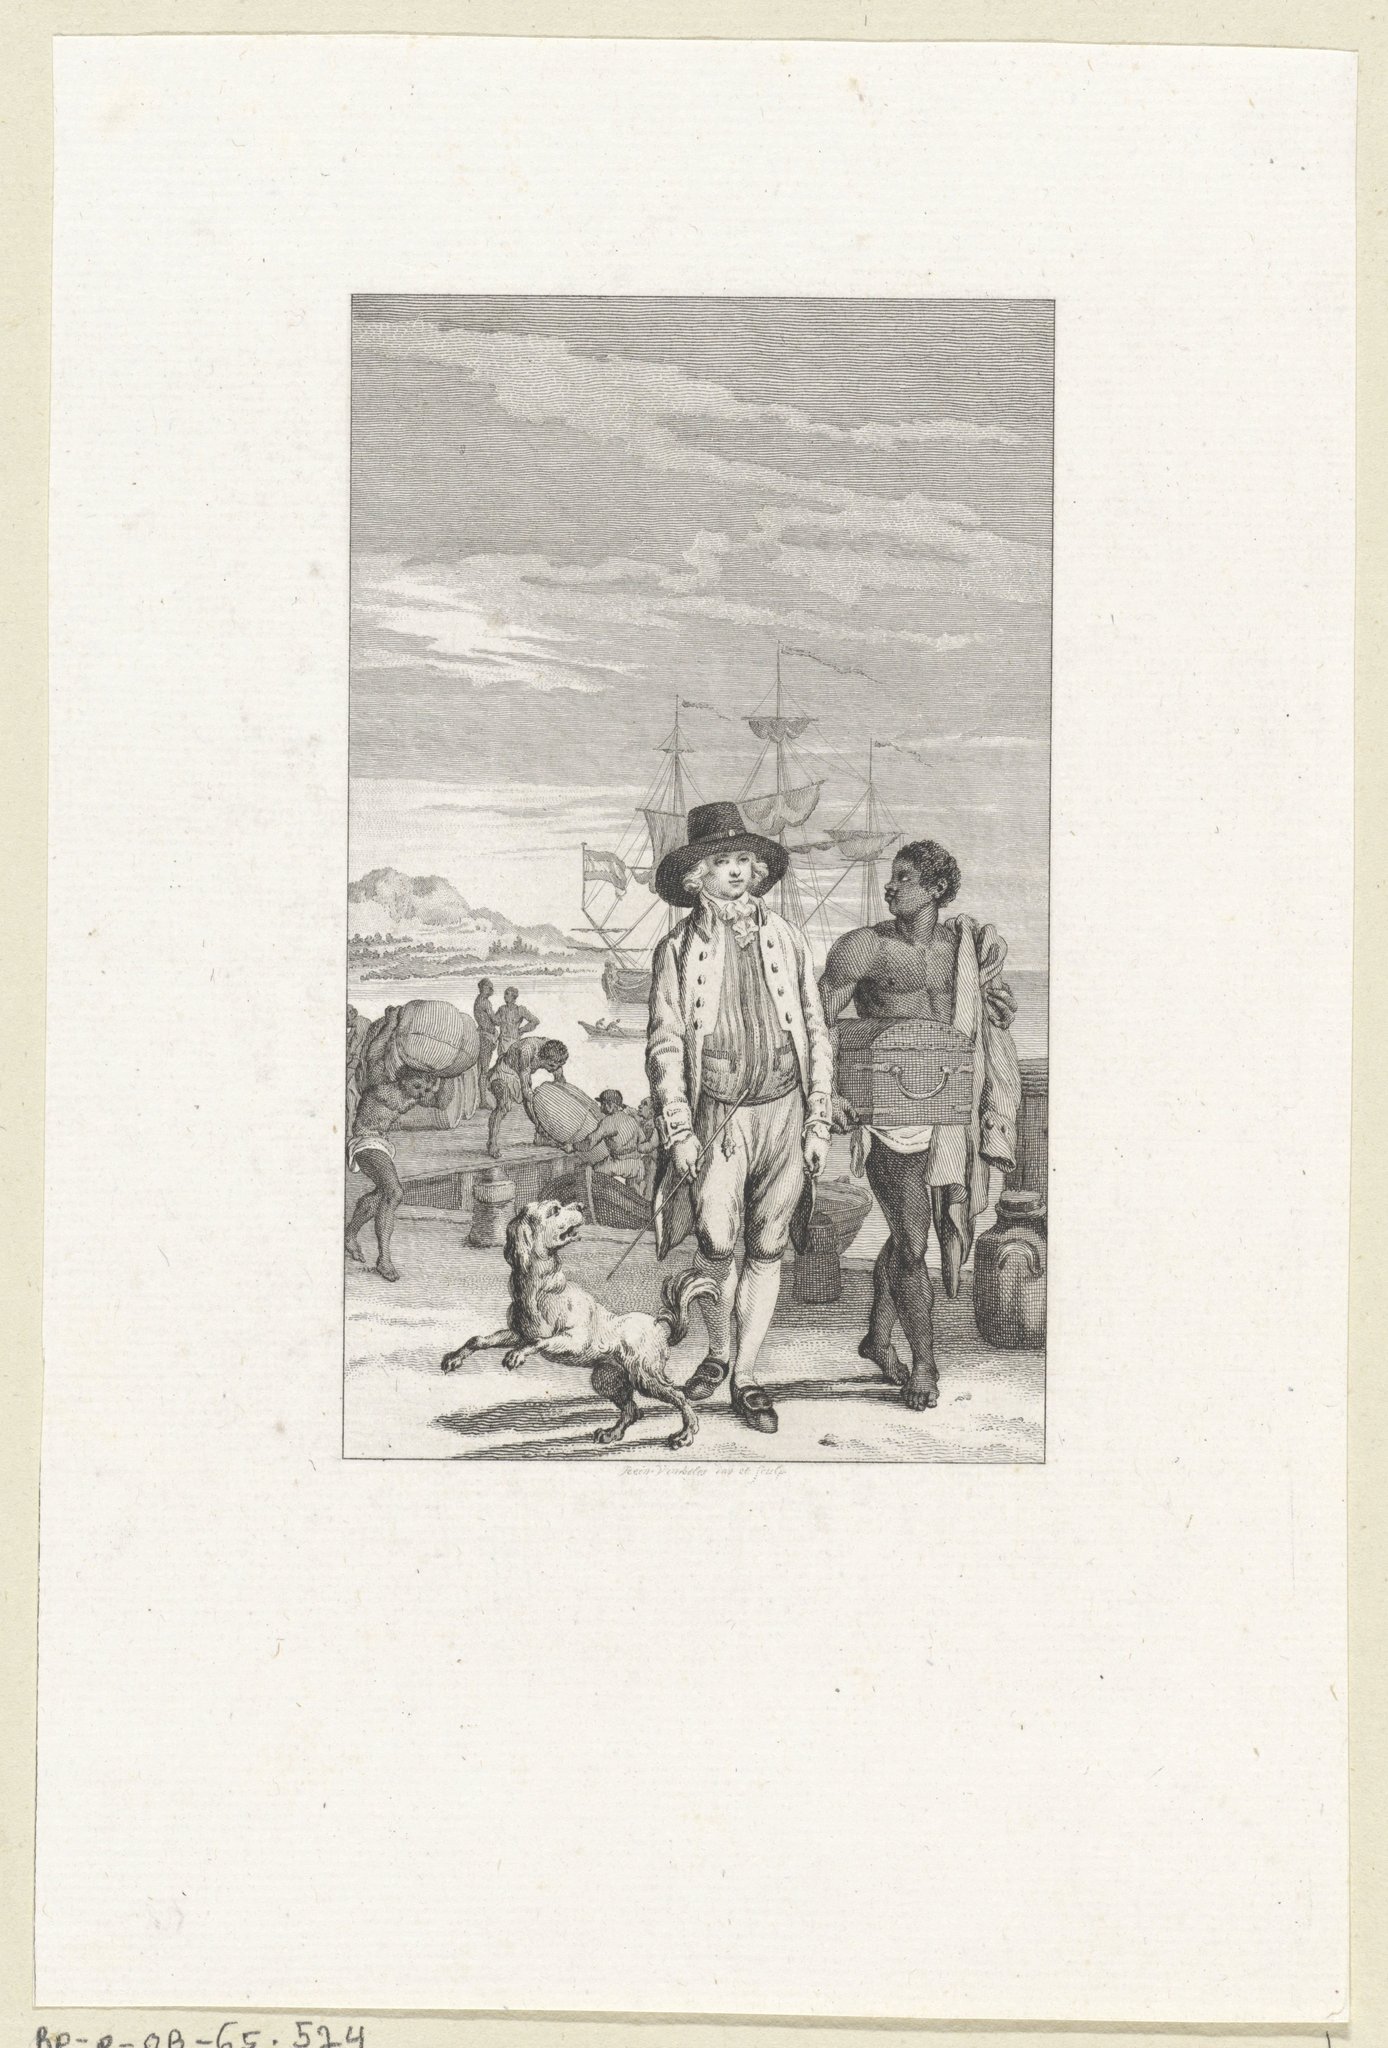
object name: print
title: Donkere man draagt Reinharts bagage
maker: reinier vinkeles (i)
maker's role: draughtsman, print maker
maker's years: 1741-1816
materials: paper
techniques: engraving, etching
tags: luggage, travel requisites, slavery; serfs and enslaved persons, human races, peoples and nationalities (other than prehistoric or extinct), quay, dog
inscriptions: collector's mark: Lugt 240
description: Latere staat van prent gebruikt in: Post, Elisabeth Maria. Reinhart, of Natuur en Godsdienst. 3 dln. 1e druk. Amsterdam: Johannes Allart, 1791-1792, dl. 1 (1791), p. 211. En in: Post, Elisabeth Maria. Reinhart, of Natuur en Godsdienst. 3 dln. 2e druk. Amsterdam: Johannes Allart, 1798-1802, dl. 1 (1798), p. 211.